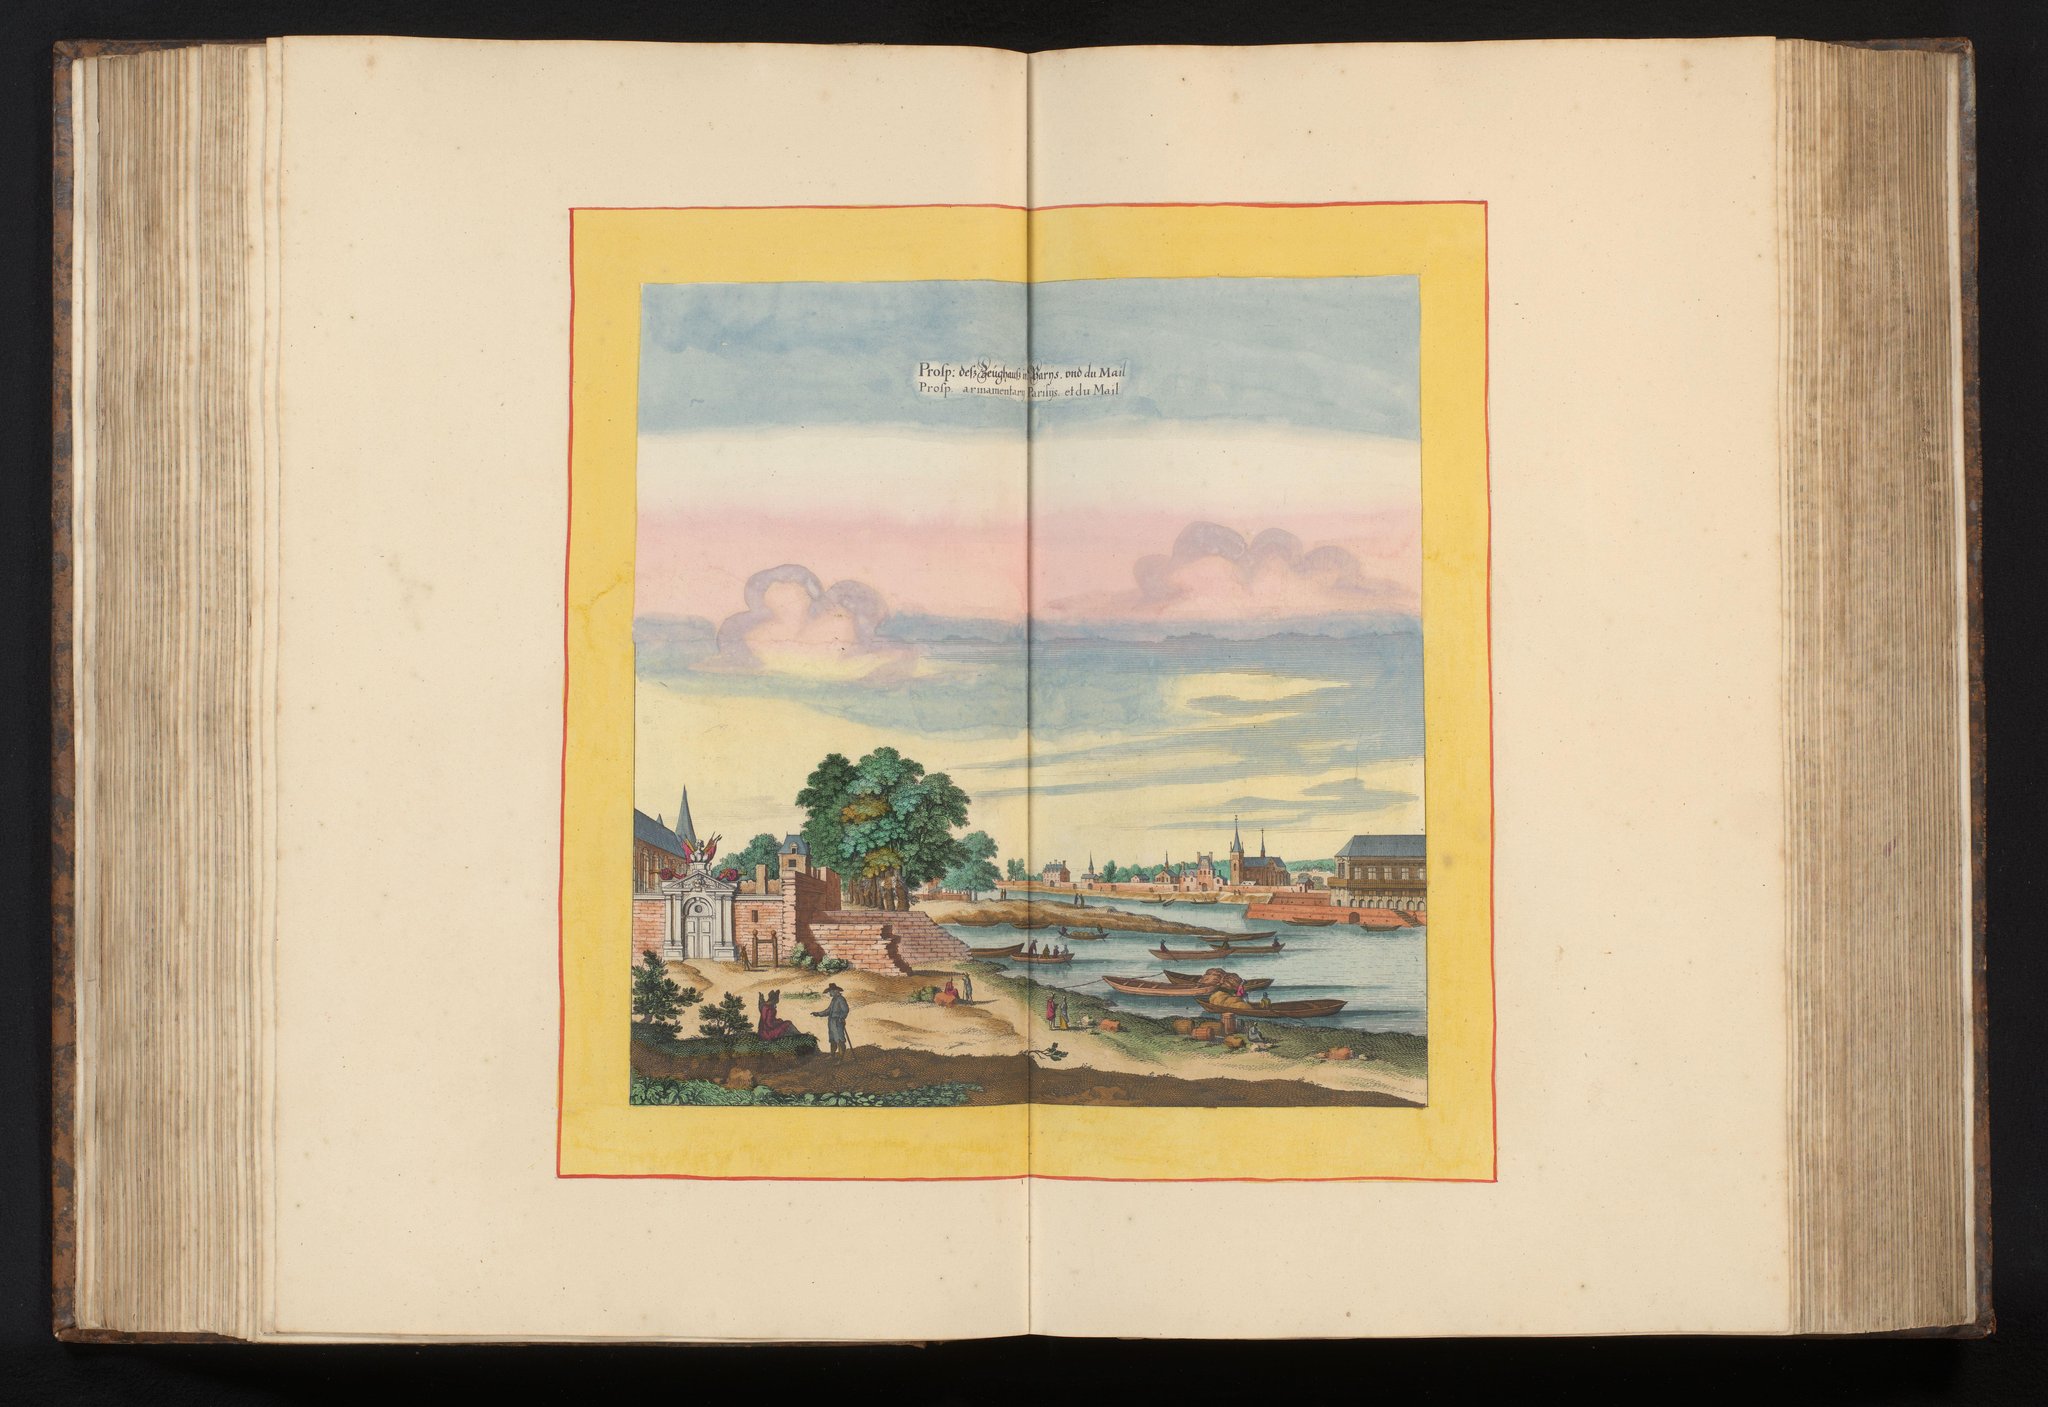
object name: album leaf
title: Gezicht op de Seine te Parijs met links het arsenaal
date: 1655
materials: paper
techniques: engraving, etching, hand coloring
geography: paris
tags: river, ammunition store, arsenal, paris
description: Prent origineel vervaardigd als boekillustratie voor: Zeiller, Martin. Topographia Galliae, oder Beschreibung und Contrafaitung der vornehmbsten und bekantisten Oerter in dem mächtigen und grossen Königreich Frankreich, 13 delen. Frankfurt am Main: Caspar Merian, 1655-1661. De prent werd voor het eerst gepubliceerd in deel 1: Topographia Galliae, 1655. De prent is langs de bovenrand van de voorstelling afgescheurd. Het bovenste gedeelte is hoger opgeplakt, zodat de lucht hoger is geworden en het formaat van de voorstelling past bij de andere groot formaatvoorstellingen in het album. De voorstelling is aan de bovenzijde aangevuld met een geschilderde lucht.